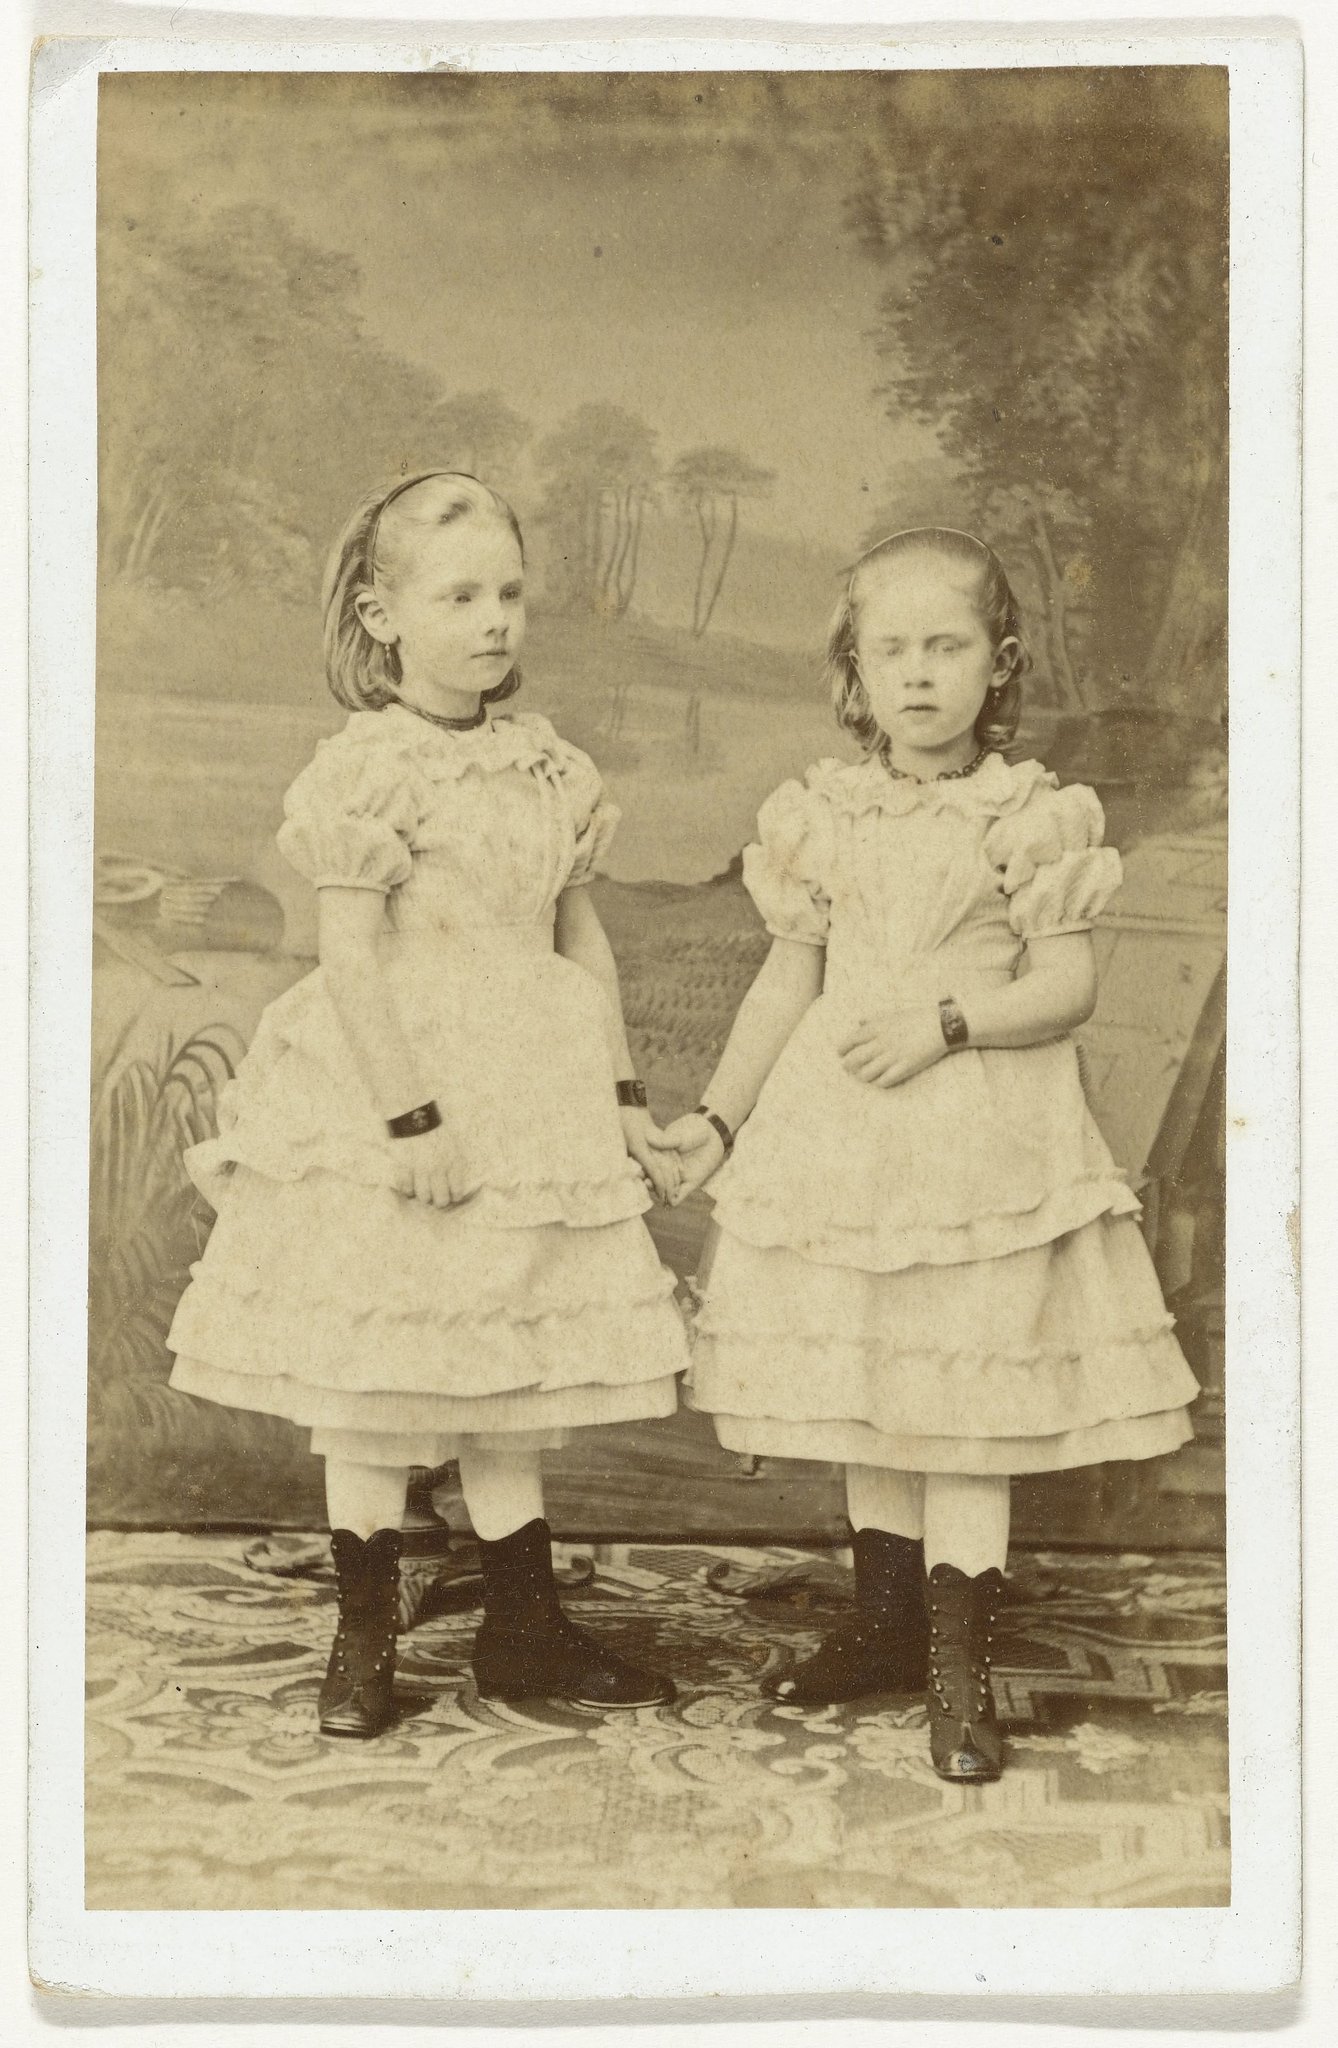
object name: photograph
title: Portret van Marie en Gertrude Werndly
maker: johann heinrich martin bosse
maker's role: fotograaf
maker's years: 1838-1901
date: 1877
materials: cardboard, paper, photographic support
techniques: albumen print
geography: deventer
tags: marie werndly, gertude werndly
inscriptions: annotation: ‘Narie en Gertrude werndly/Deventer 1877’, address: ‘Photogr. MB Atelier/M. Bosse/Assenstraat en Bursesteeg/Deventer’, annotation: ‘Voor nabestellingen blijft de plaat bewaard./Vergrootingen naar ieder klein portret.’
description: Twee staande meisjes in licht jurjes,hand in hand. Een afbeelding van een parklandschap als achtergrond.